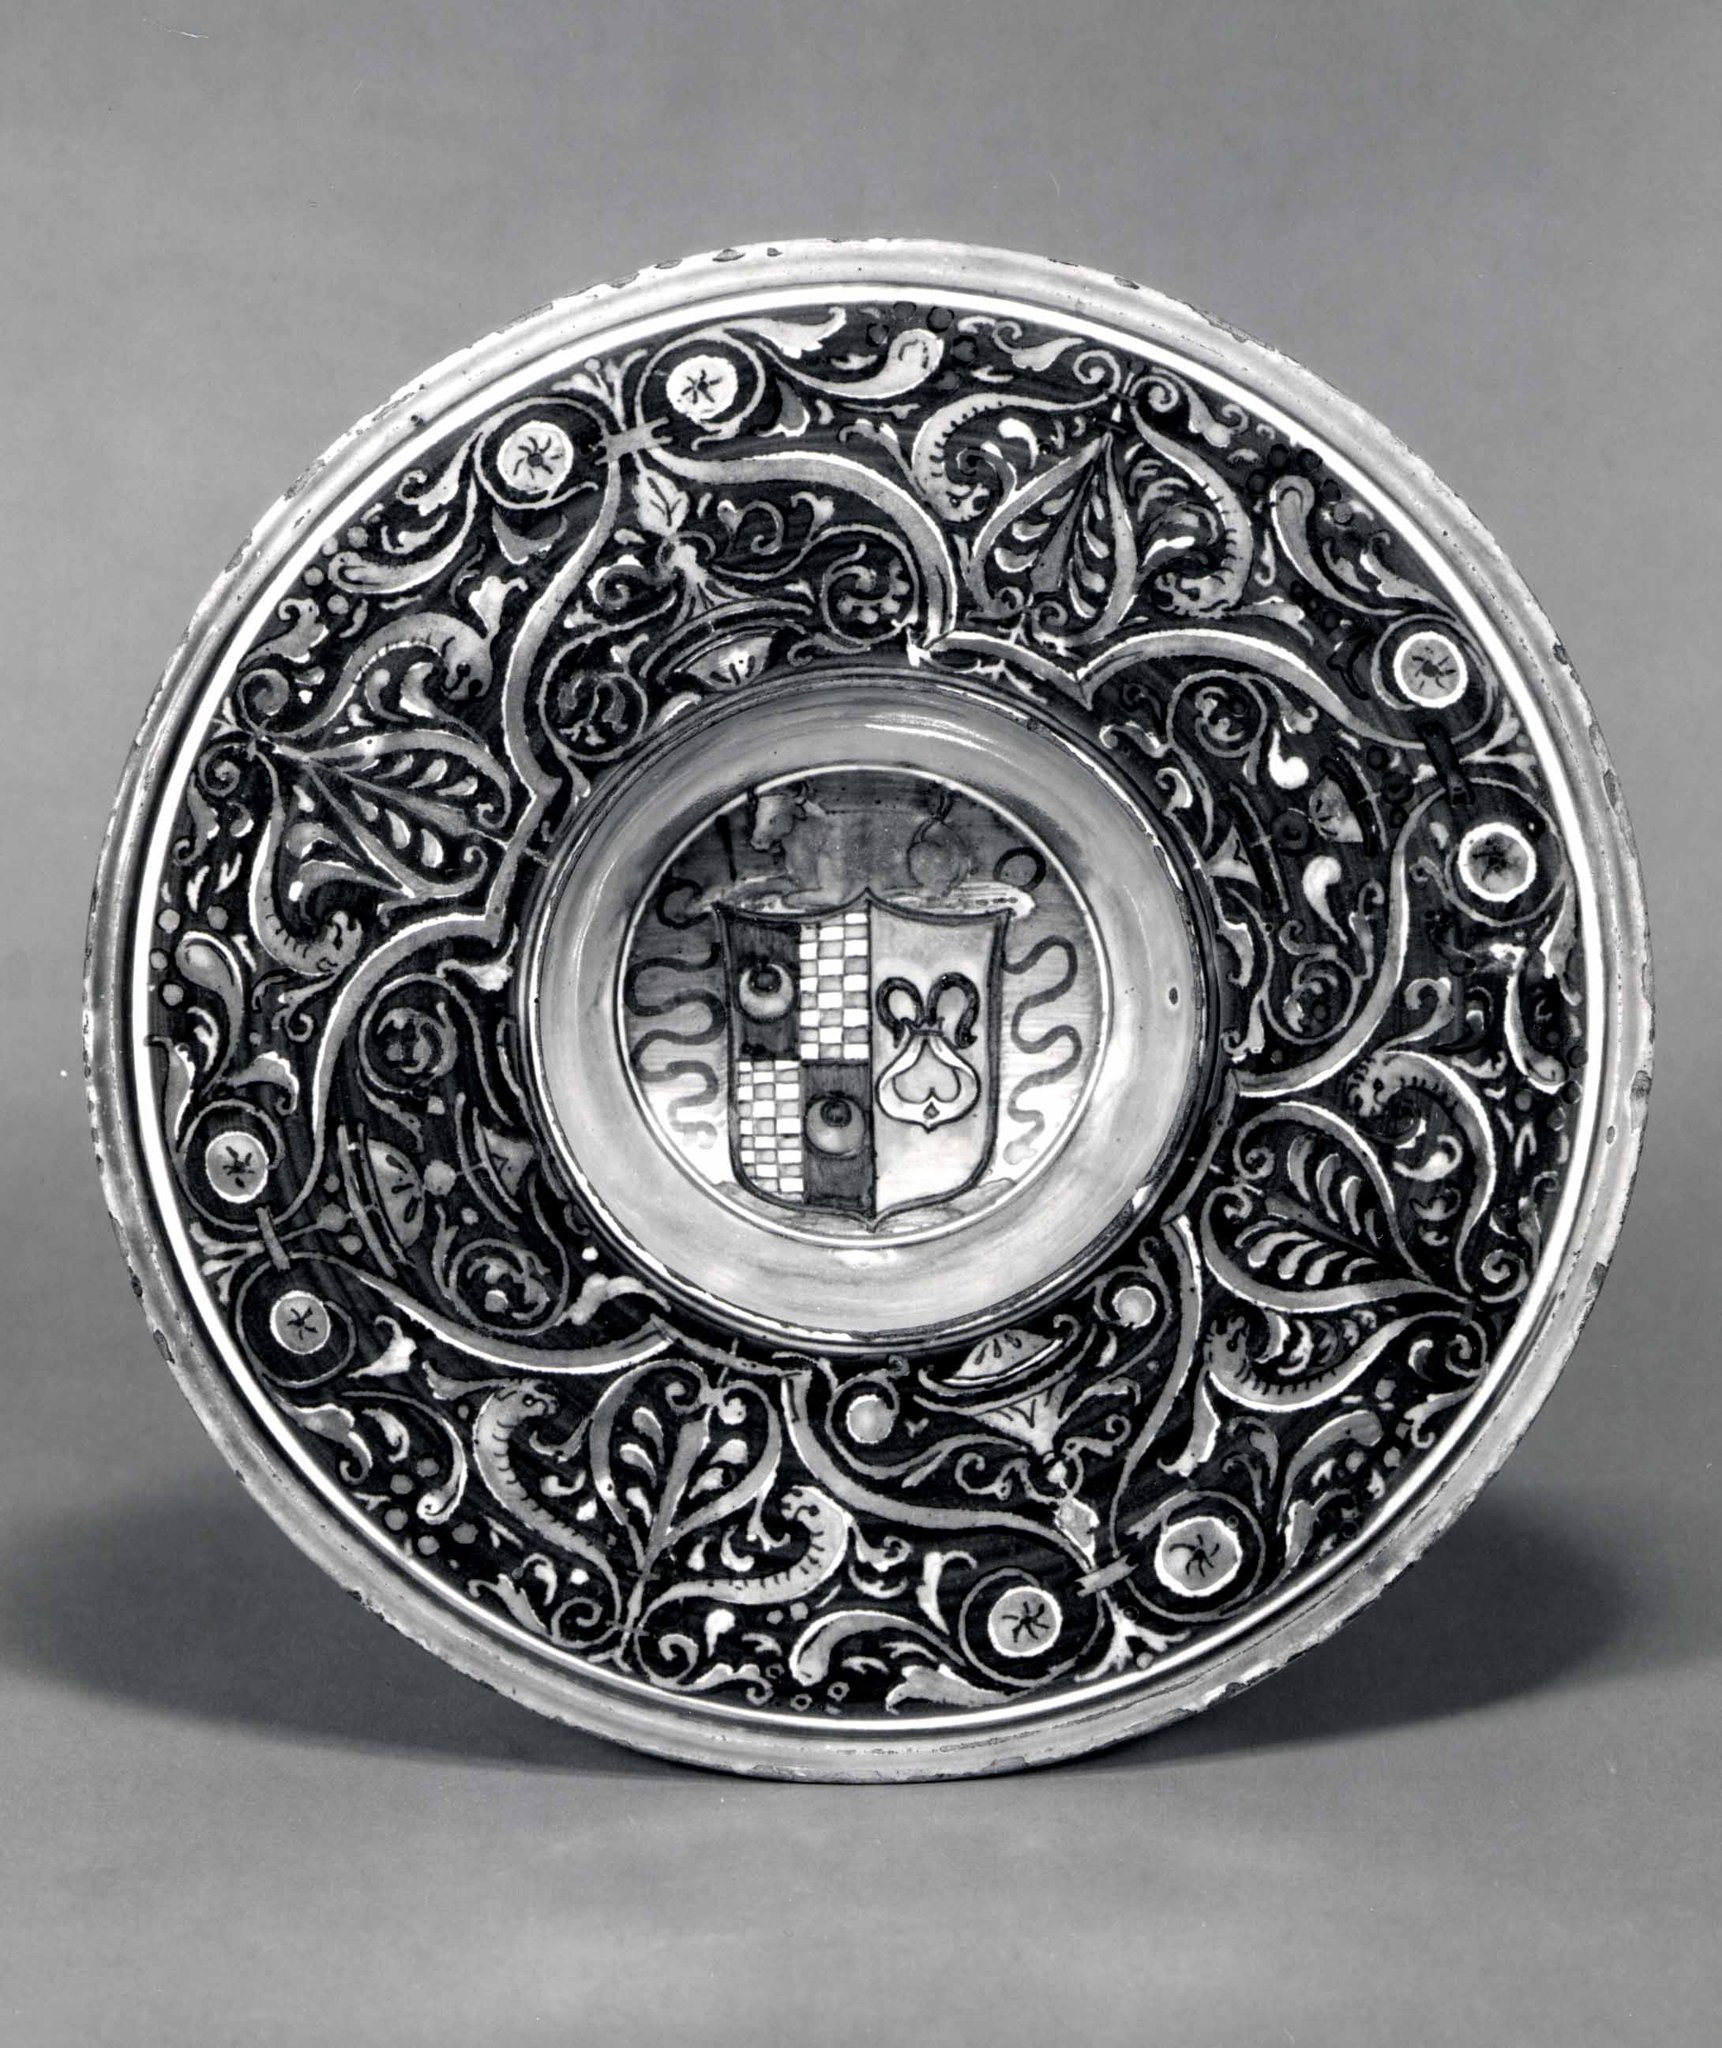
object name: plate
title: Plate (tondino)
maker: maestro giorgio andreoli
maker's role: artist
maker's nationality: italian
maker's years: 1500-1550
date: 1527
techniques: maiolica, glazing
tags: coat of arms